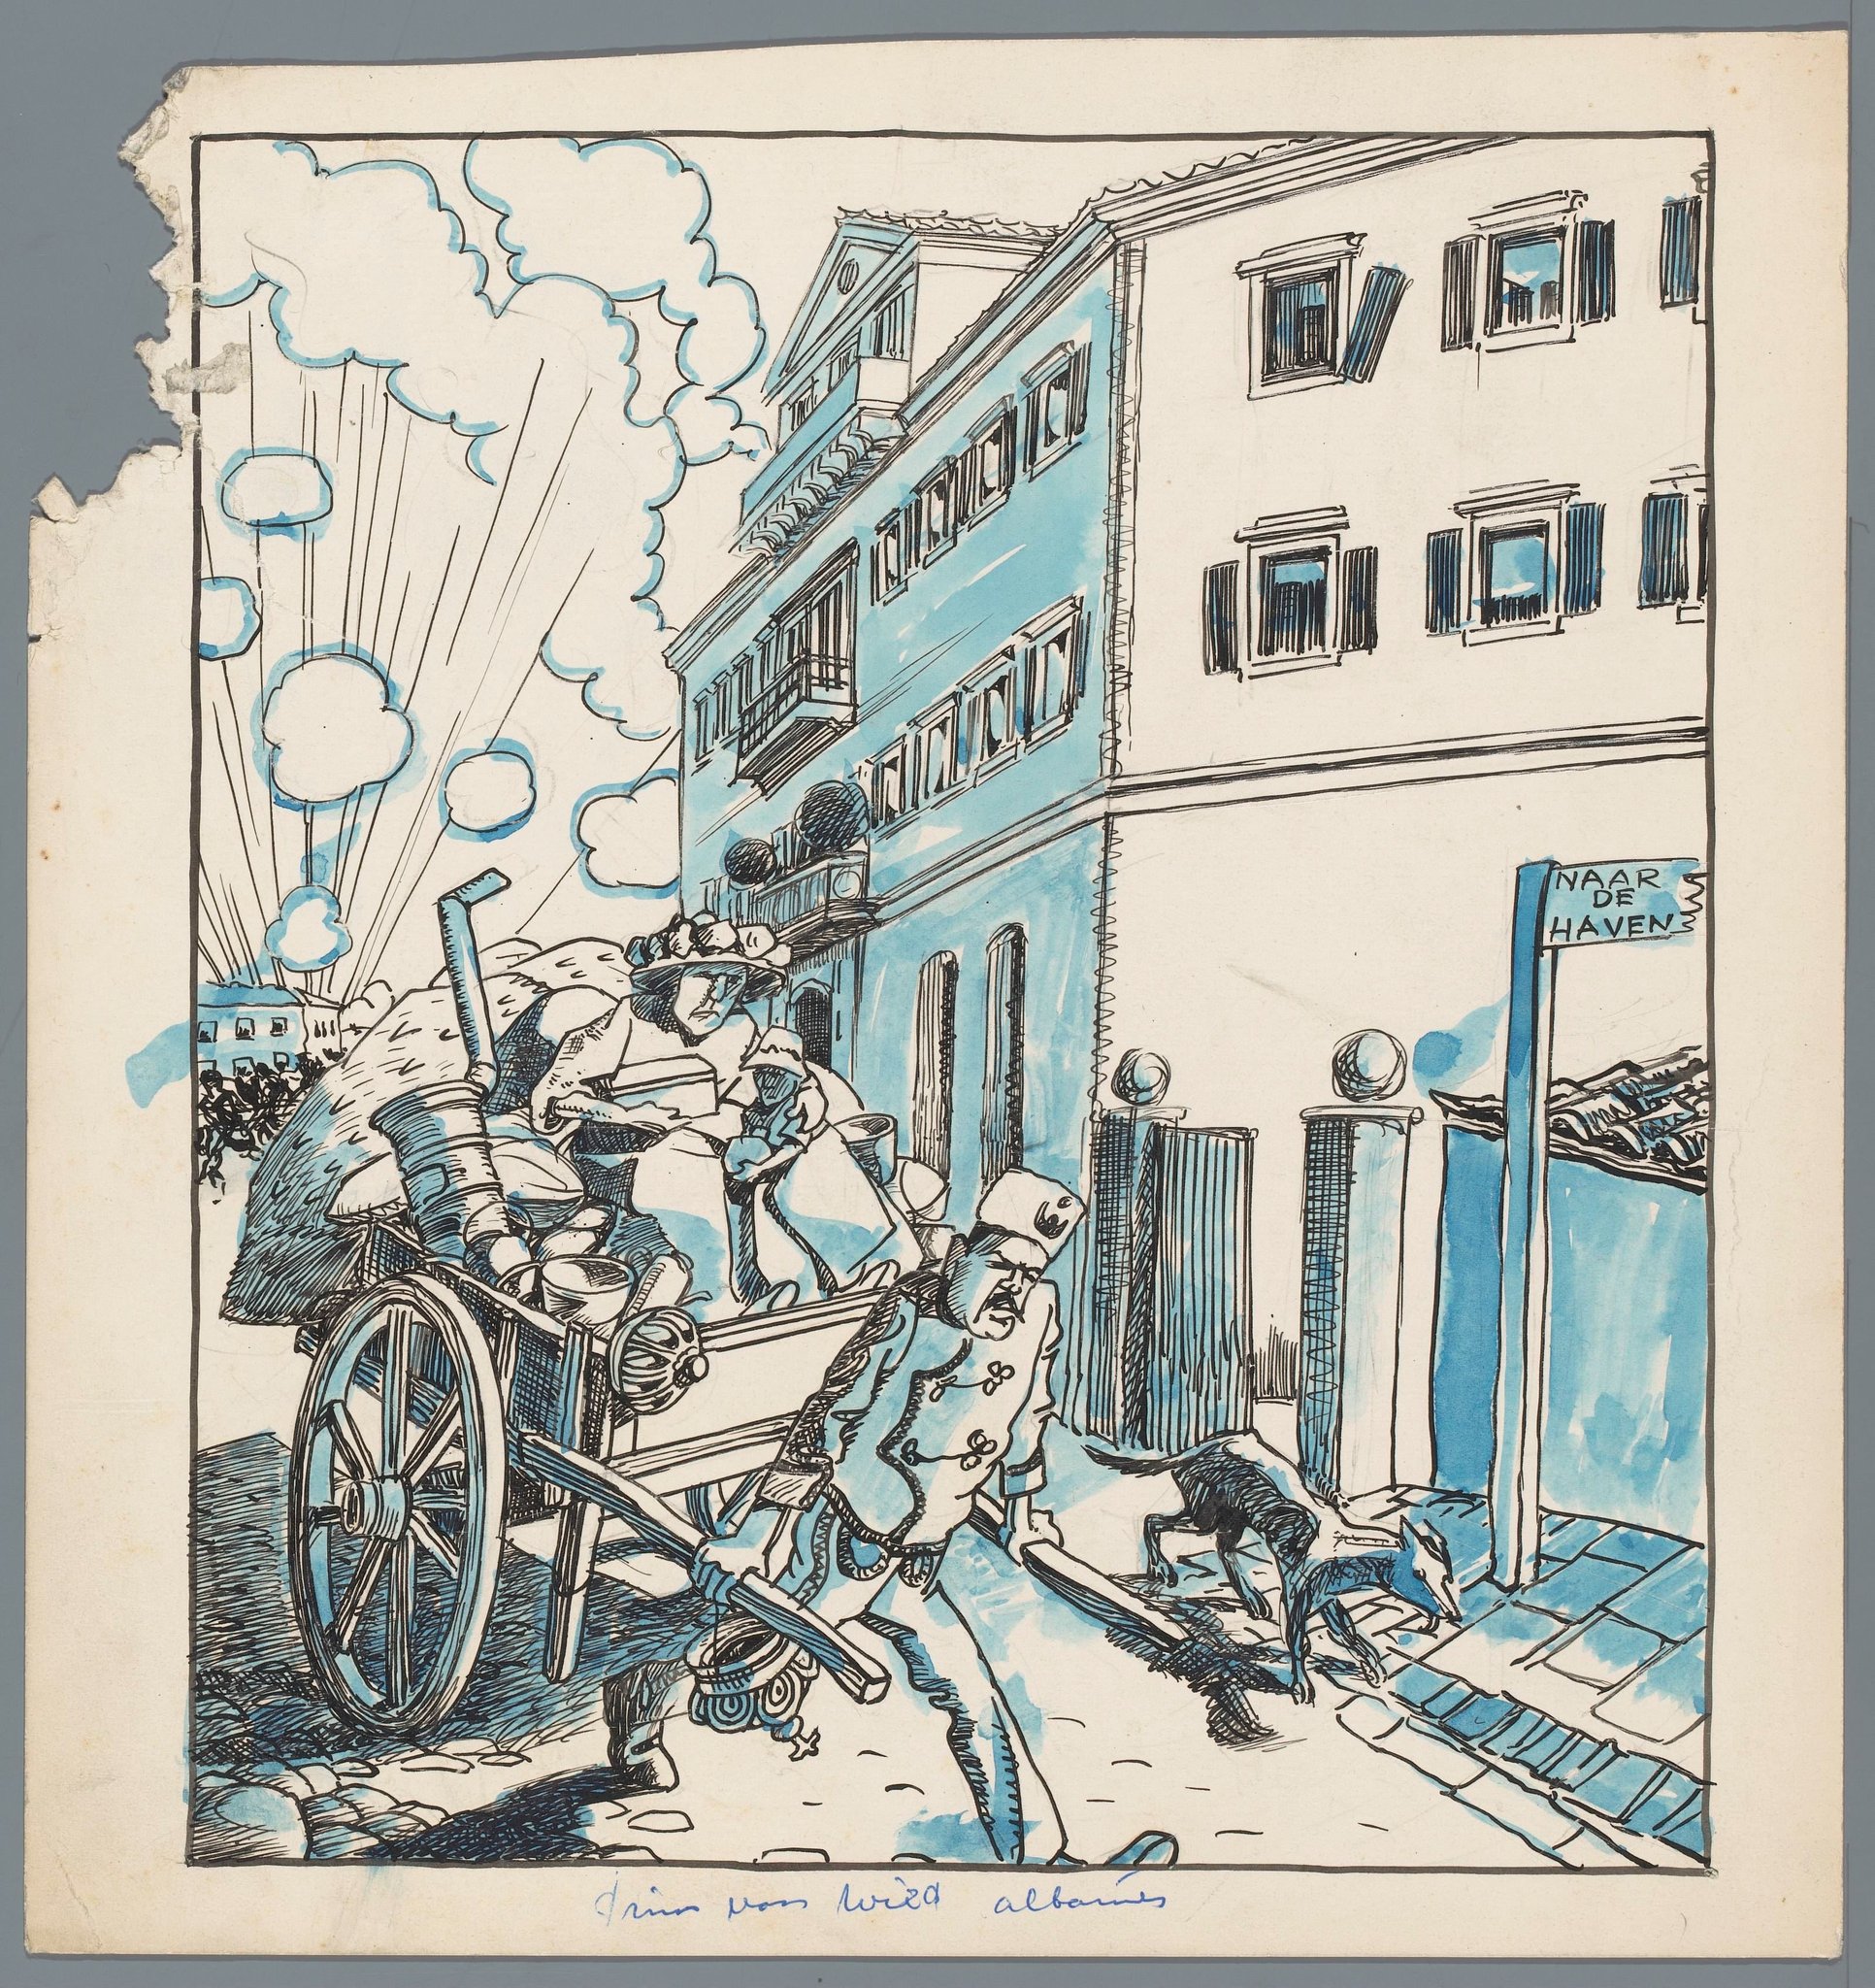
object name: cartoon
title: Prins von Wied Albanie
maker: patricq kroon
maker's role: draughtsman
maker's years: 1862-1941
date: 1914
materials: ink, paper, pencil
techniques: brush, pen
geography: netherlands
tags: fugitives 'en route', political caricatures and satires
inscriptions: inscription: ‘Prins von Wied Albanie’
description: Spotprent op de vlucht van Wilhelm zu Wied uit Albanië in 1914. De vorst vlucht met een kar waarop vrouw en kind en al zijn bezittingen, op de achtergrond rookwolken van ontploffingen. Ontwerp voor een politieke spotprent.